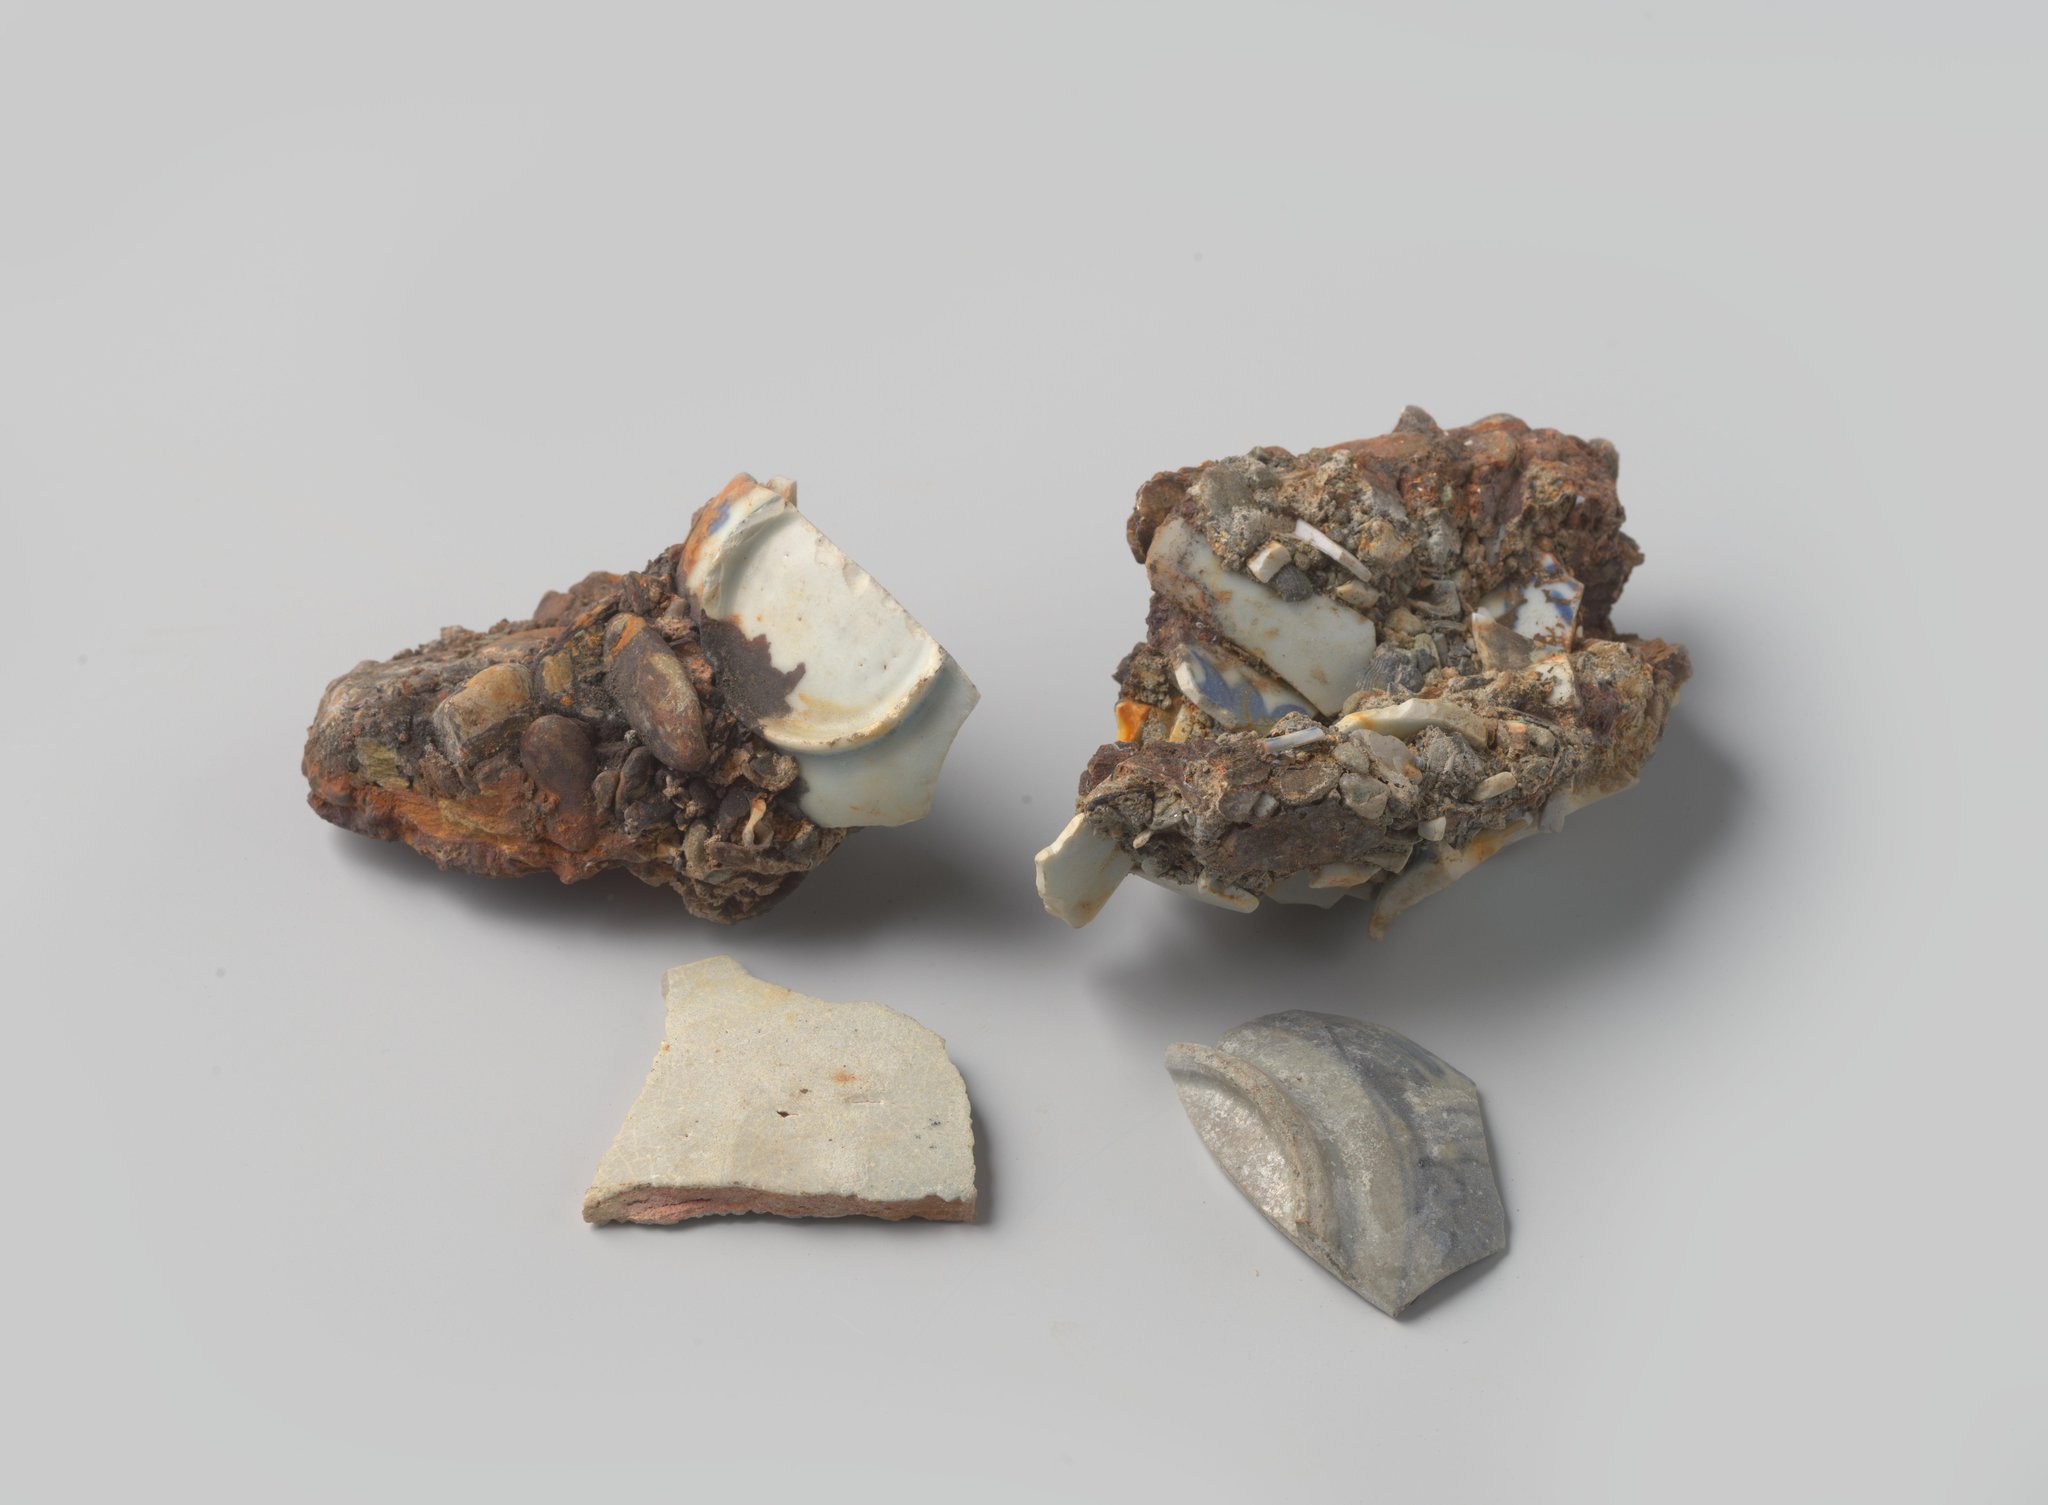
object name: concretionary stone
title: Brokken concretie met insluitsels van natuursteen en porselein en porseleinen scherven uit het wrak van de Oostindiëvaarder Hollandia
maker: Anonymous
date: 1700-1743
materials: stone, porcelain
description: Brokken concretie met insluitsels van natuursteen en porselein en drie losse porseleinen scherven.